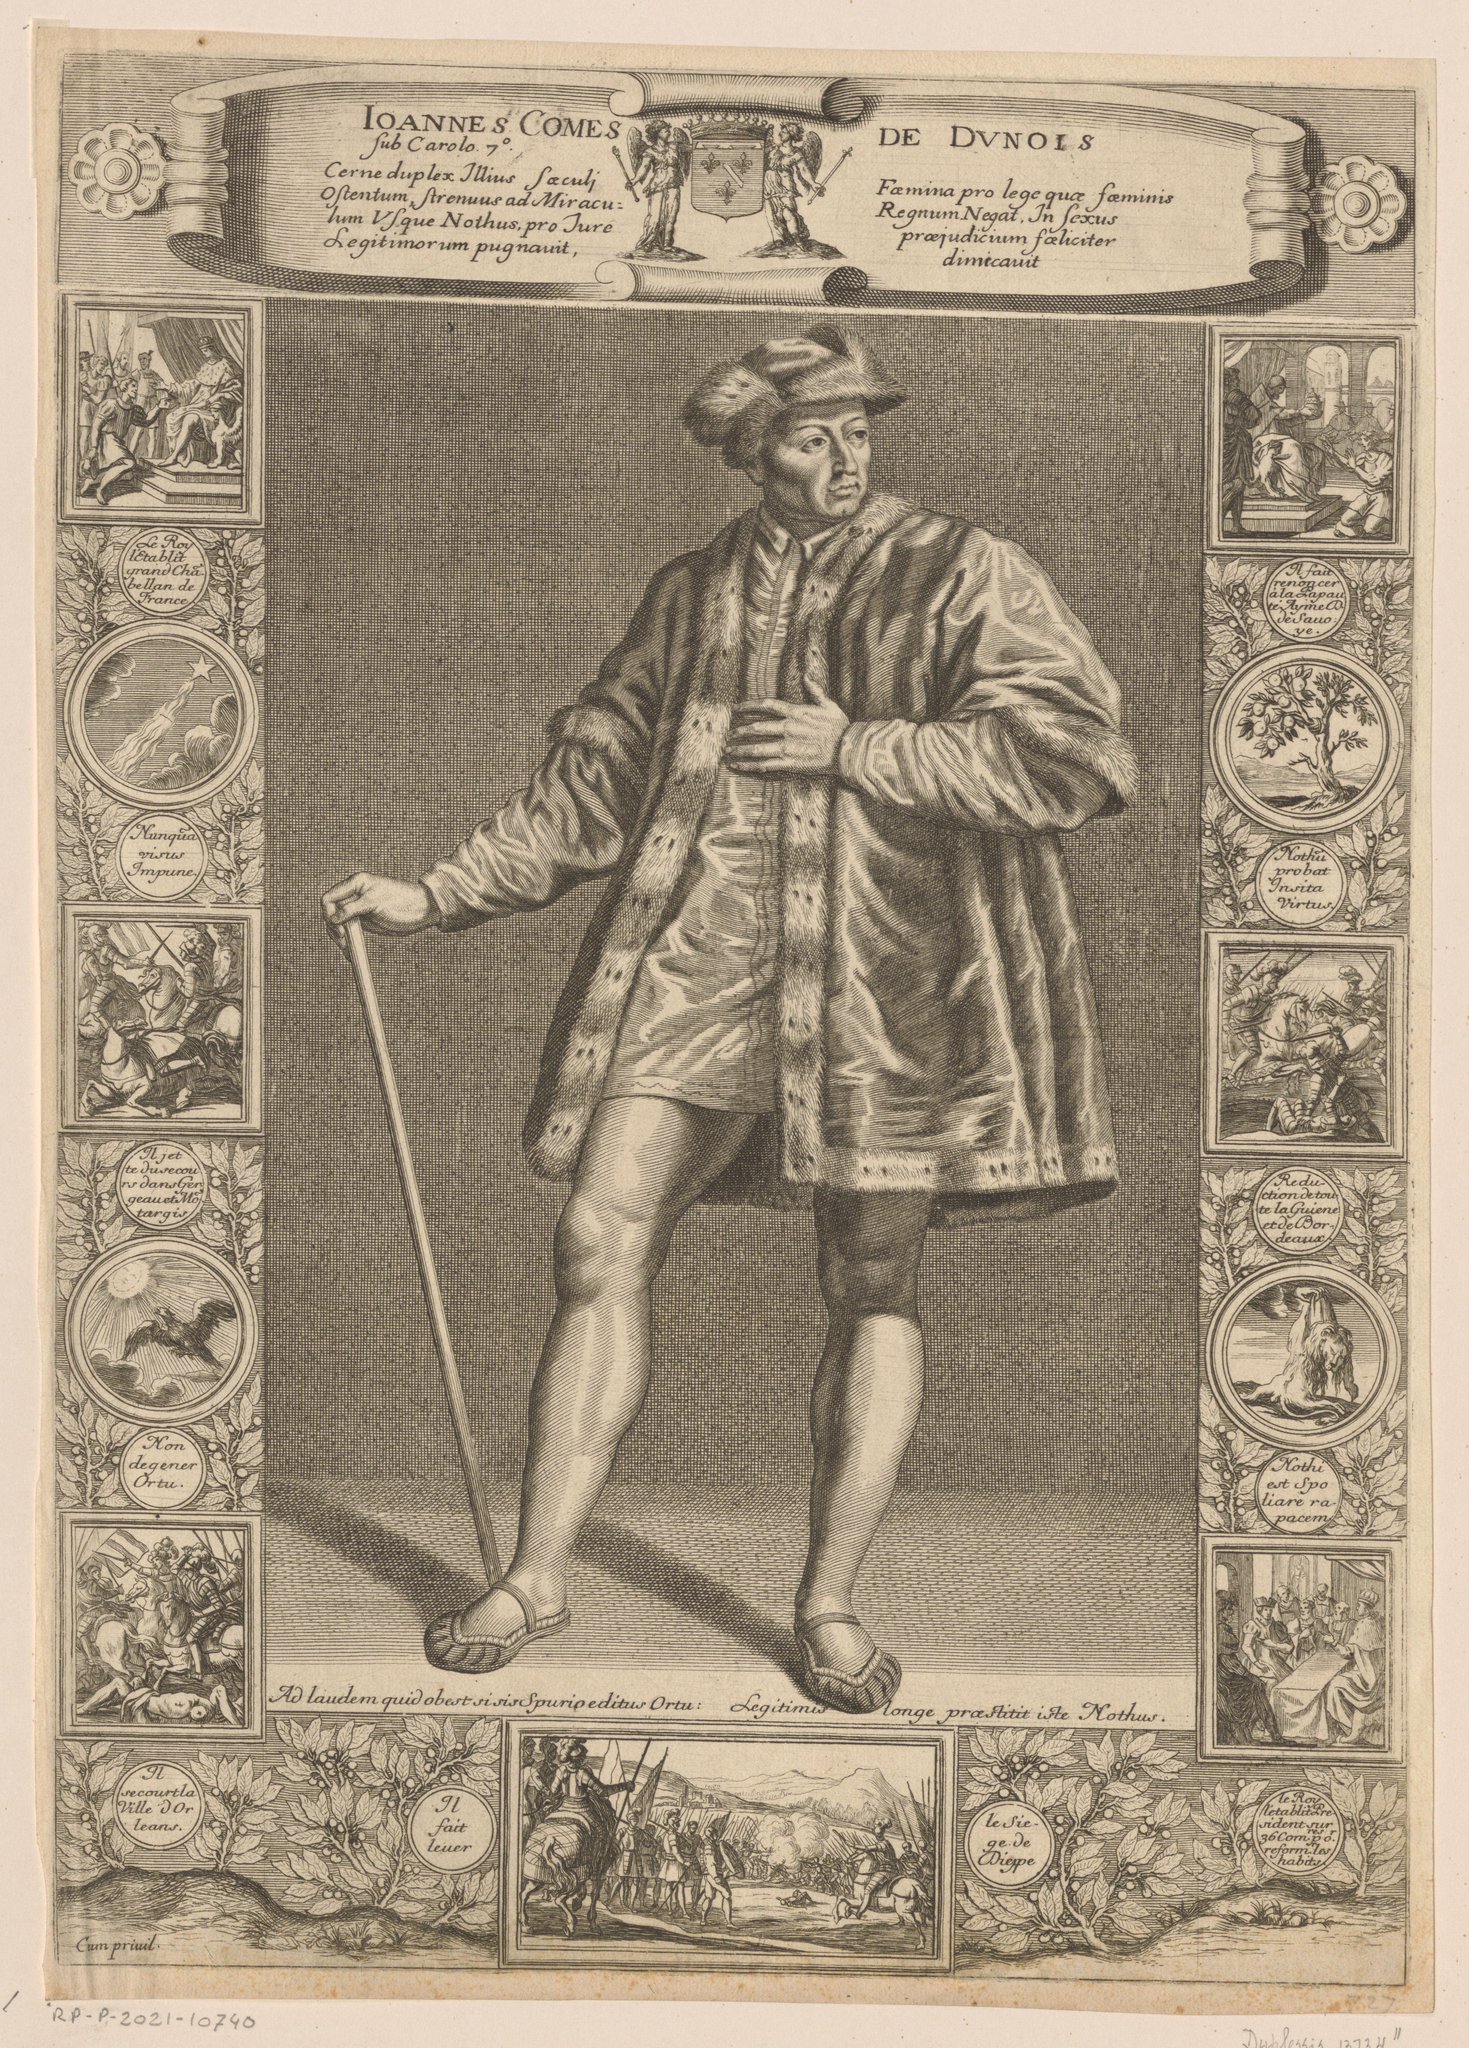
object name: print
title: Portretten uit het paleis van kardinaal de Richelieu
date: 1650-1690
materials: paper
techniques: engraving, etching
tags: earl, trees, predatory birds: eagle, historical persons, battle, trees: olive-tree, armorial bearing, heraldry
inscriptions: collector's mark: Lugt 2228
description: Prent mogelijk uit: Vulson de La Colombière, Marc de. Les portraits des hommes illustres François qui sont peints dans la gallerie du Palais cardinal de Richelieu (...). Parijs: Henry Sara et al., 1650. Of uit latere publicaties (1655, 1662, 1690 en 1690).